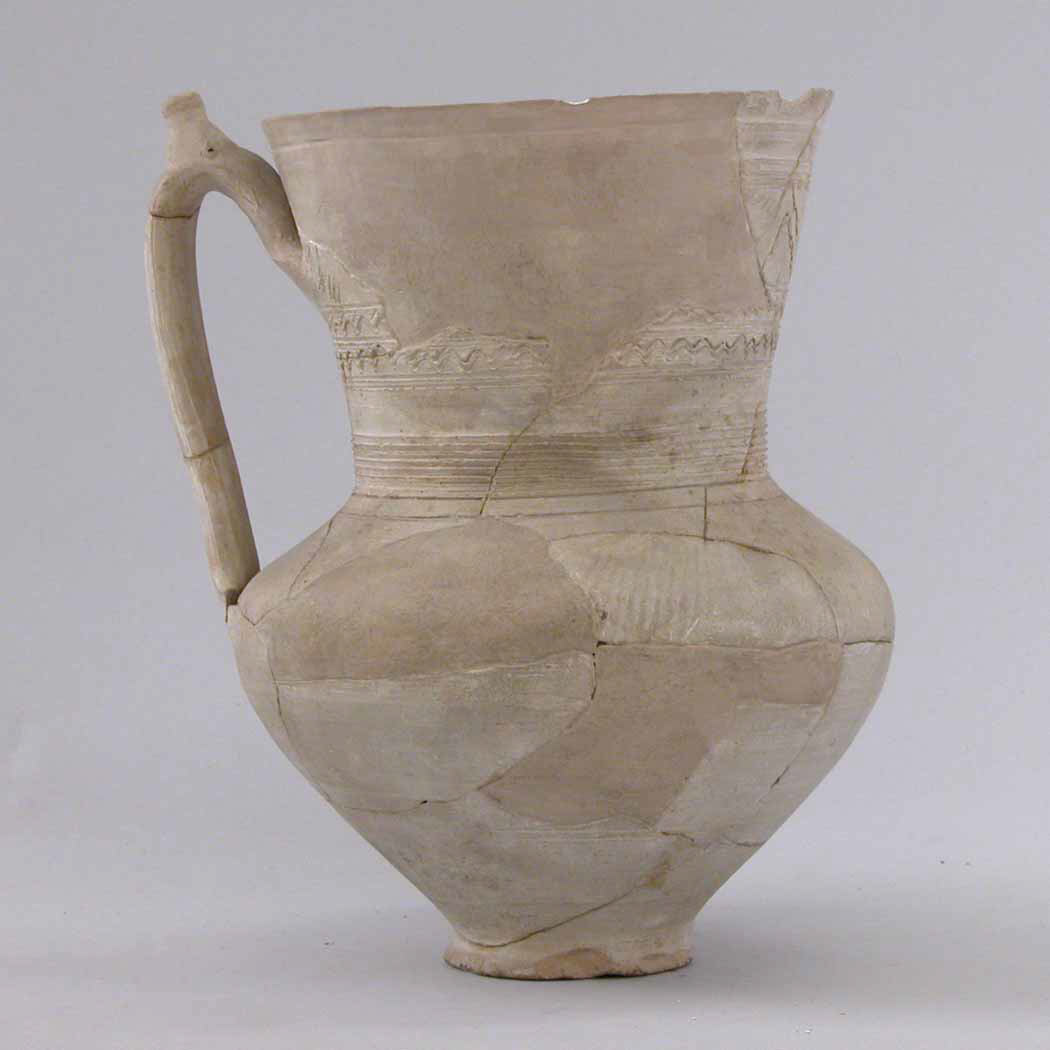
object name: jug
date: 901-1000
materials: earthenware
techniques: incising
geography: iran